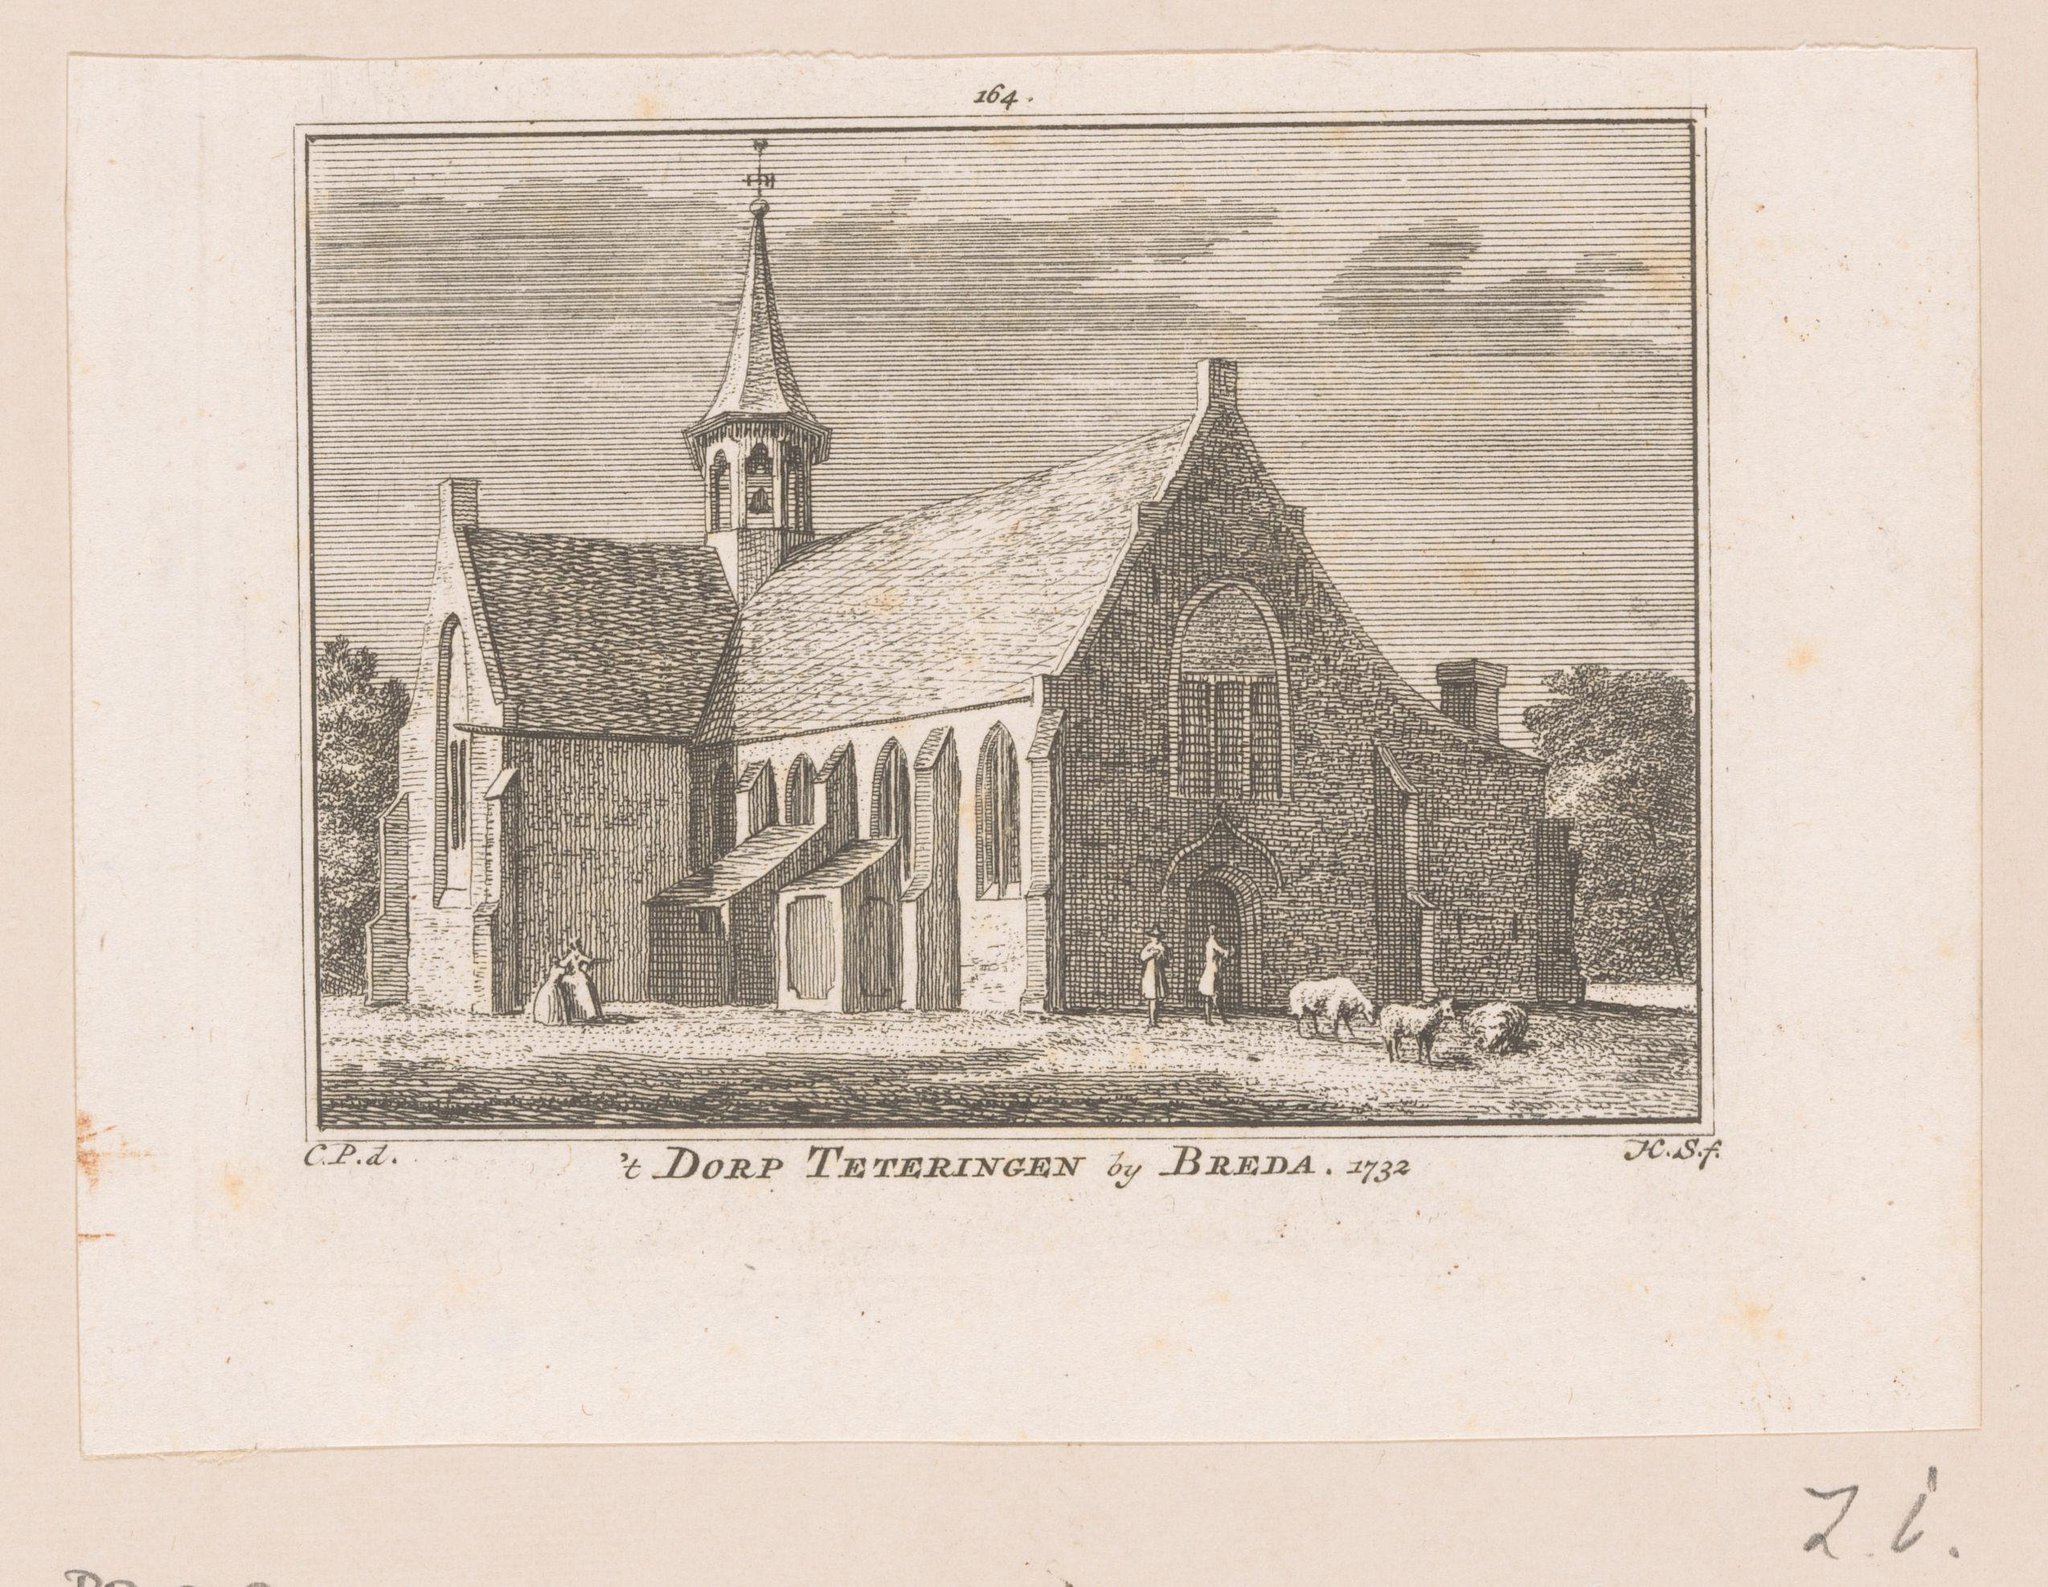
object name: print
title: 't Dorp Teteringen by Breda. 1732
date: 1746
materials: paper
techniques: engraving, etching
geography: amsterdam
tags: church (exterior)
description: Prent uit: Spilman, Hendrik. Het verheerlykt Nederland, of kabinet van hedendaagsche gezigten. 9 dln. Amsterdam: Isaac Tirion, 1745-1774, dl. 2 (1746).